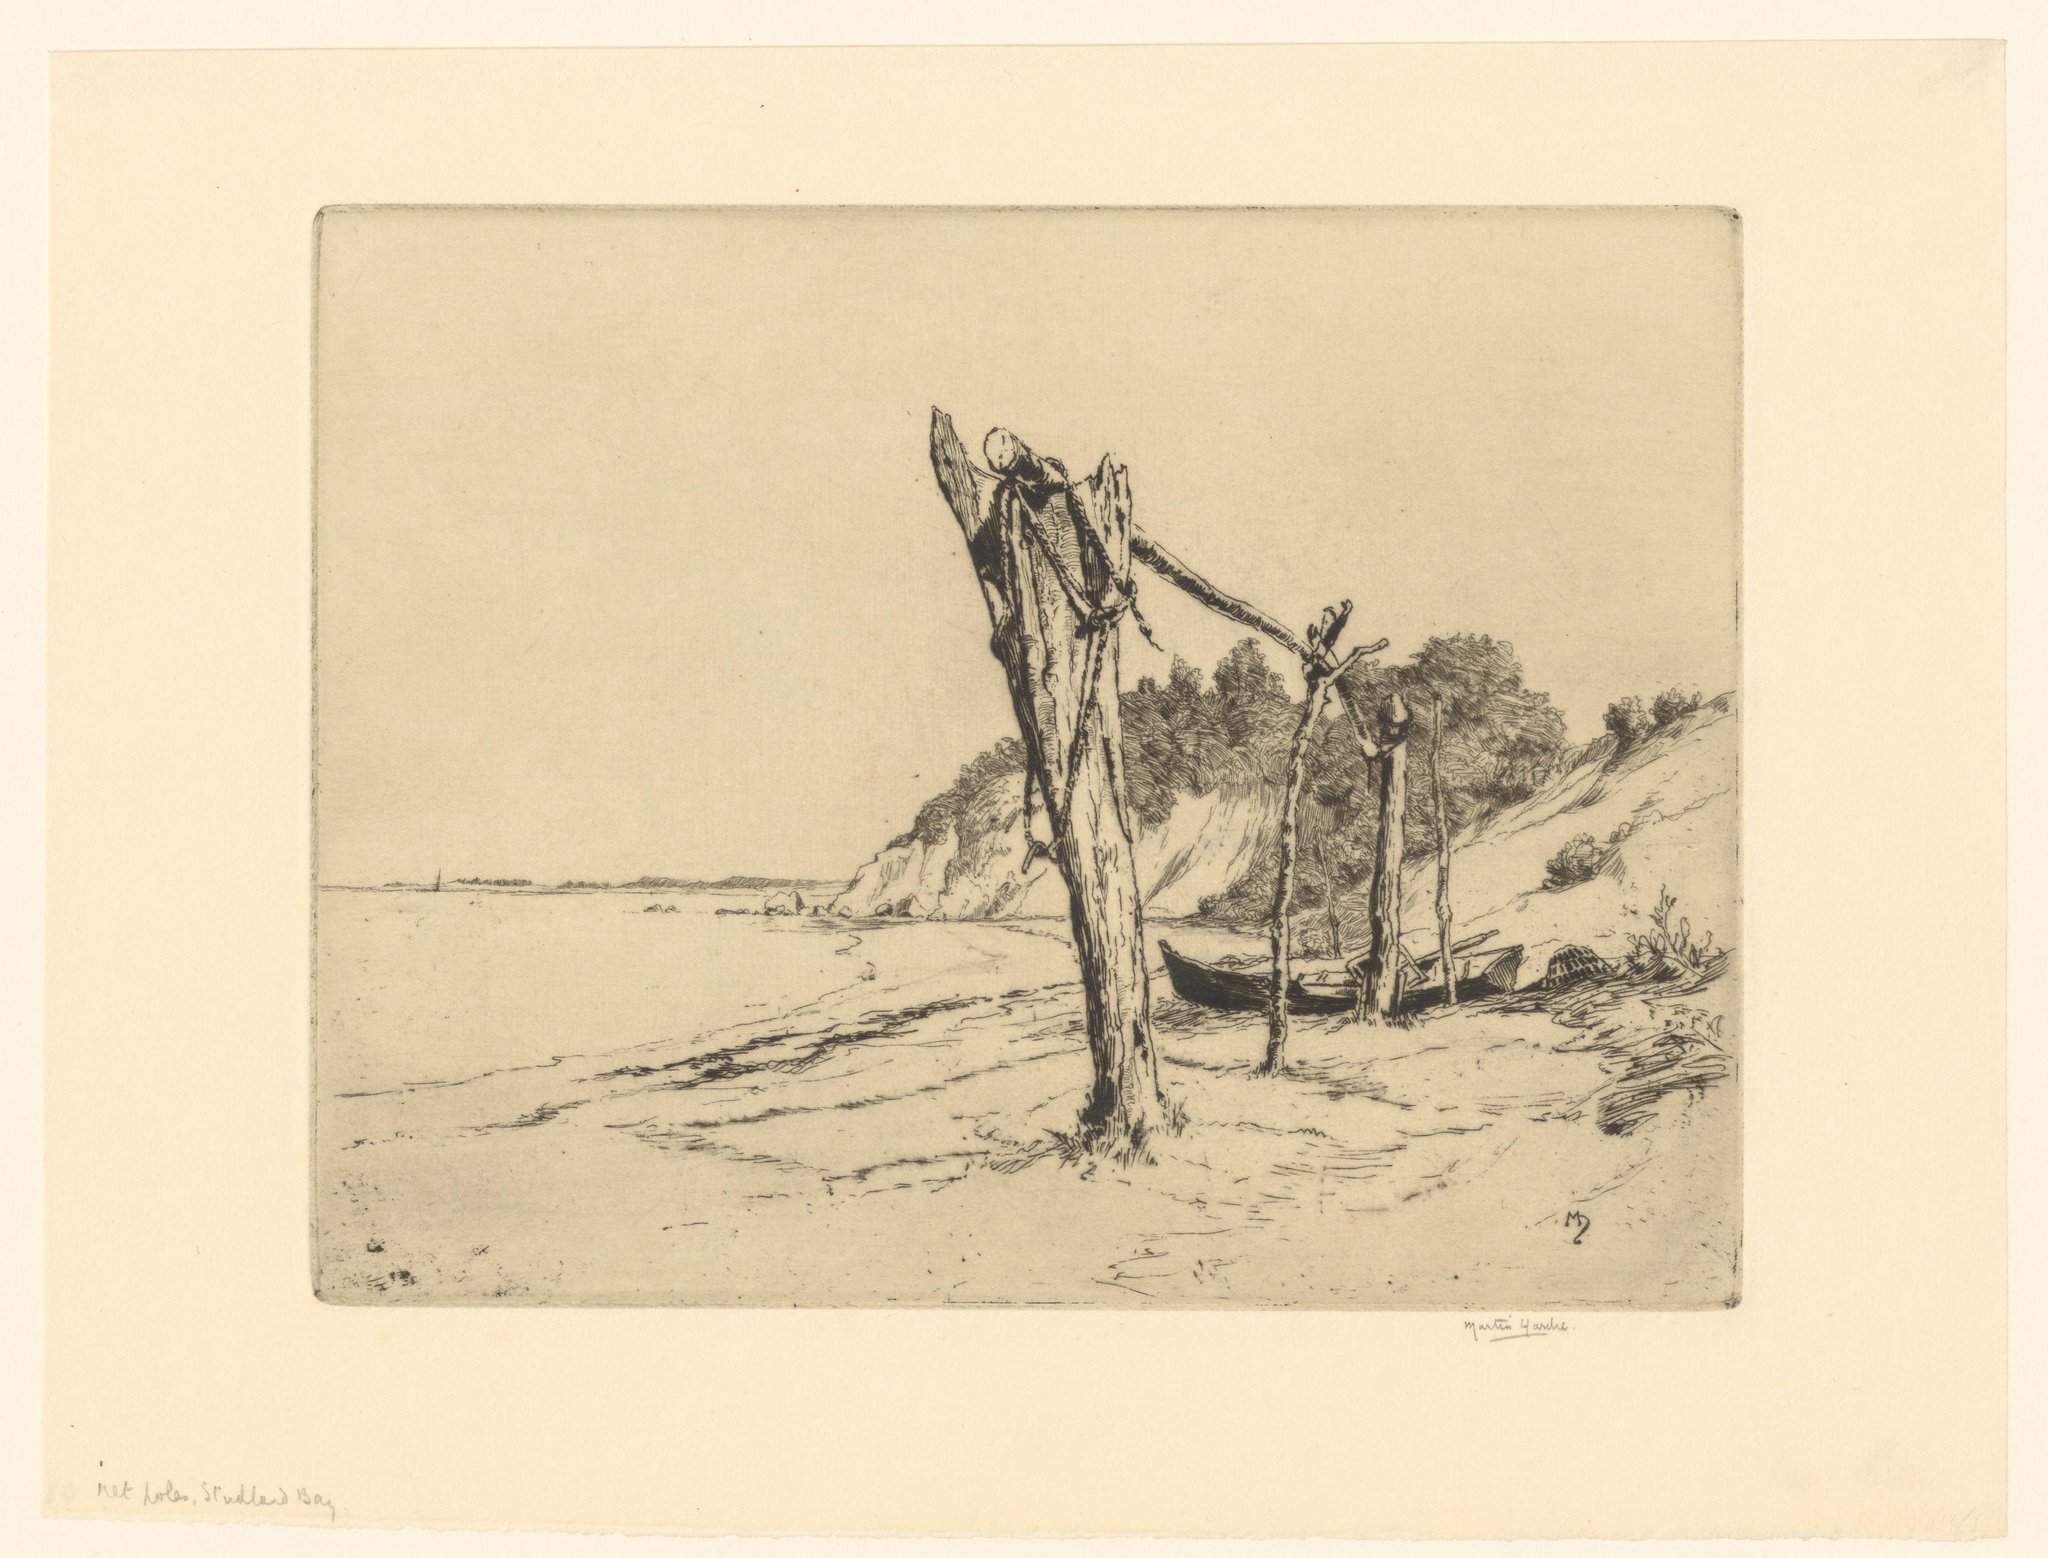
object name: print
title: Kustlijn bij Studland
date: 1912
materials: paper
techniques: drypoint, etching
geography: studland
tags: dunes (sea not visible); in the dunes, beach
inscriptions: annotation: ‘Martin Hardie’, collector's mark: Lugt 2760, collector's mark: Lugt 2228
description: Palen waarover vissersnetten werden opgehangen vooraan.